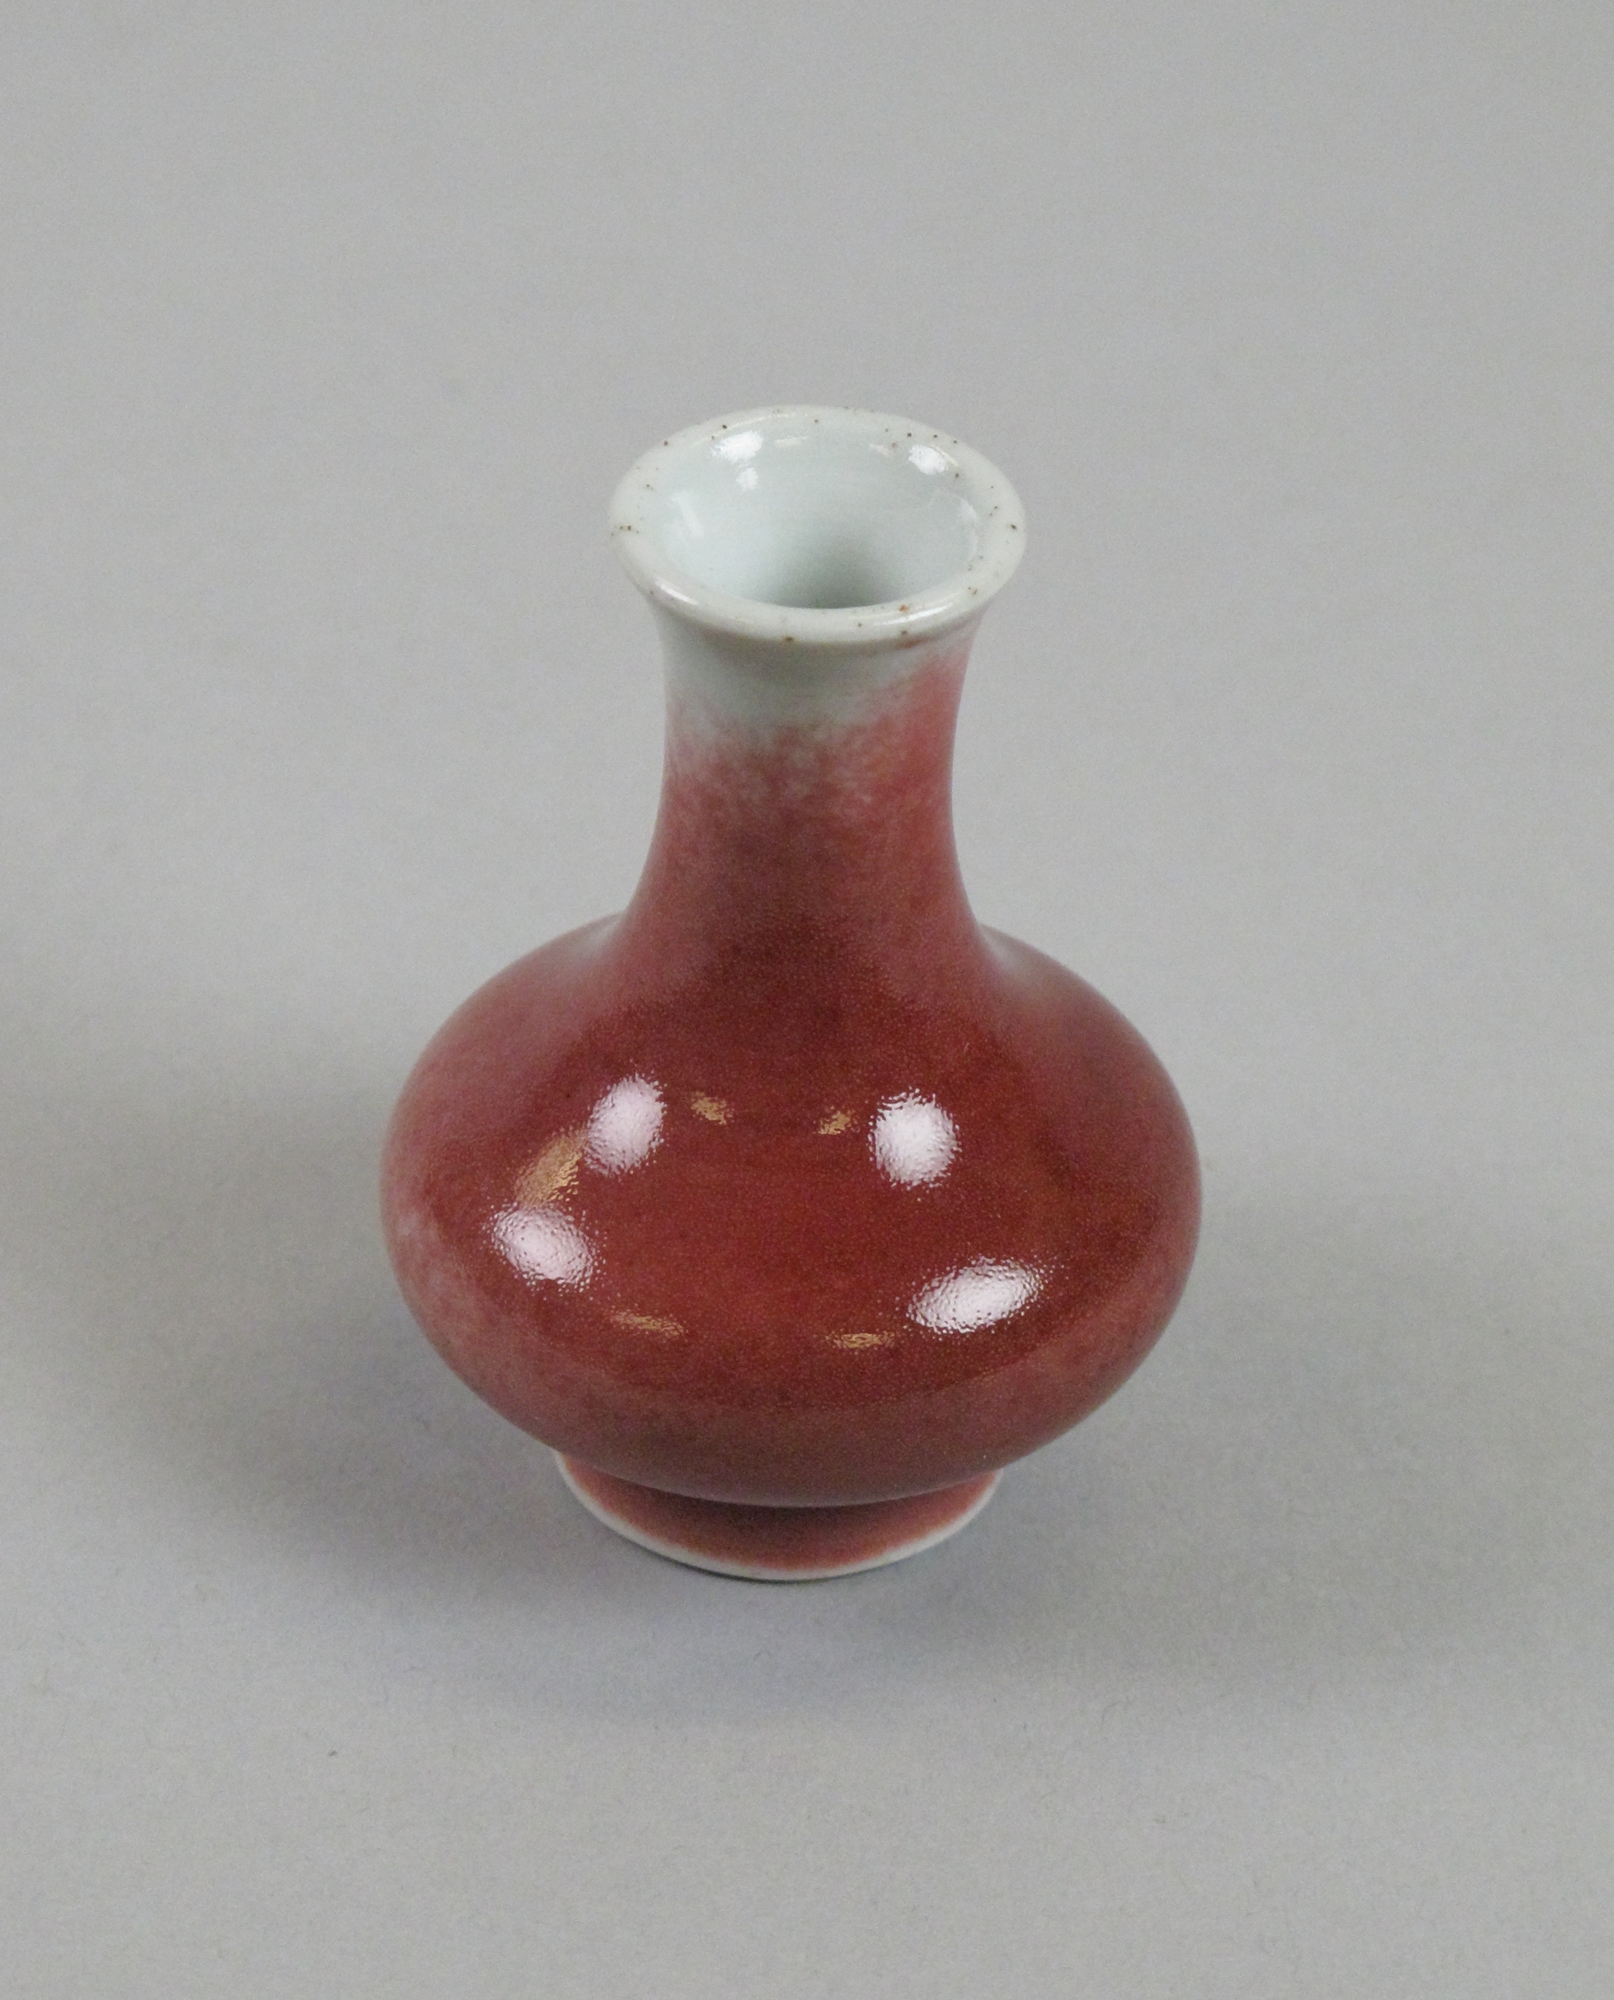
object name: vase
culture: chinese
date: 1801-1900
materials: copper, glaze, porcelain